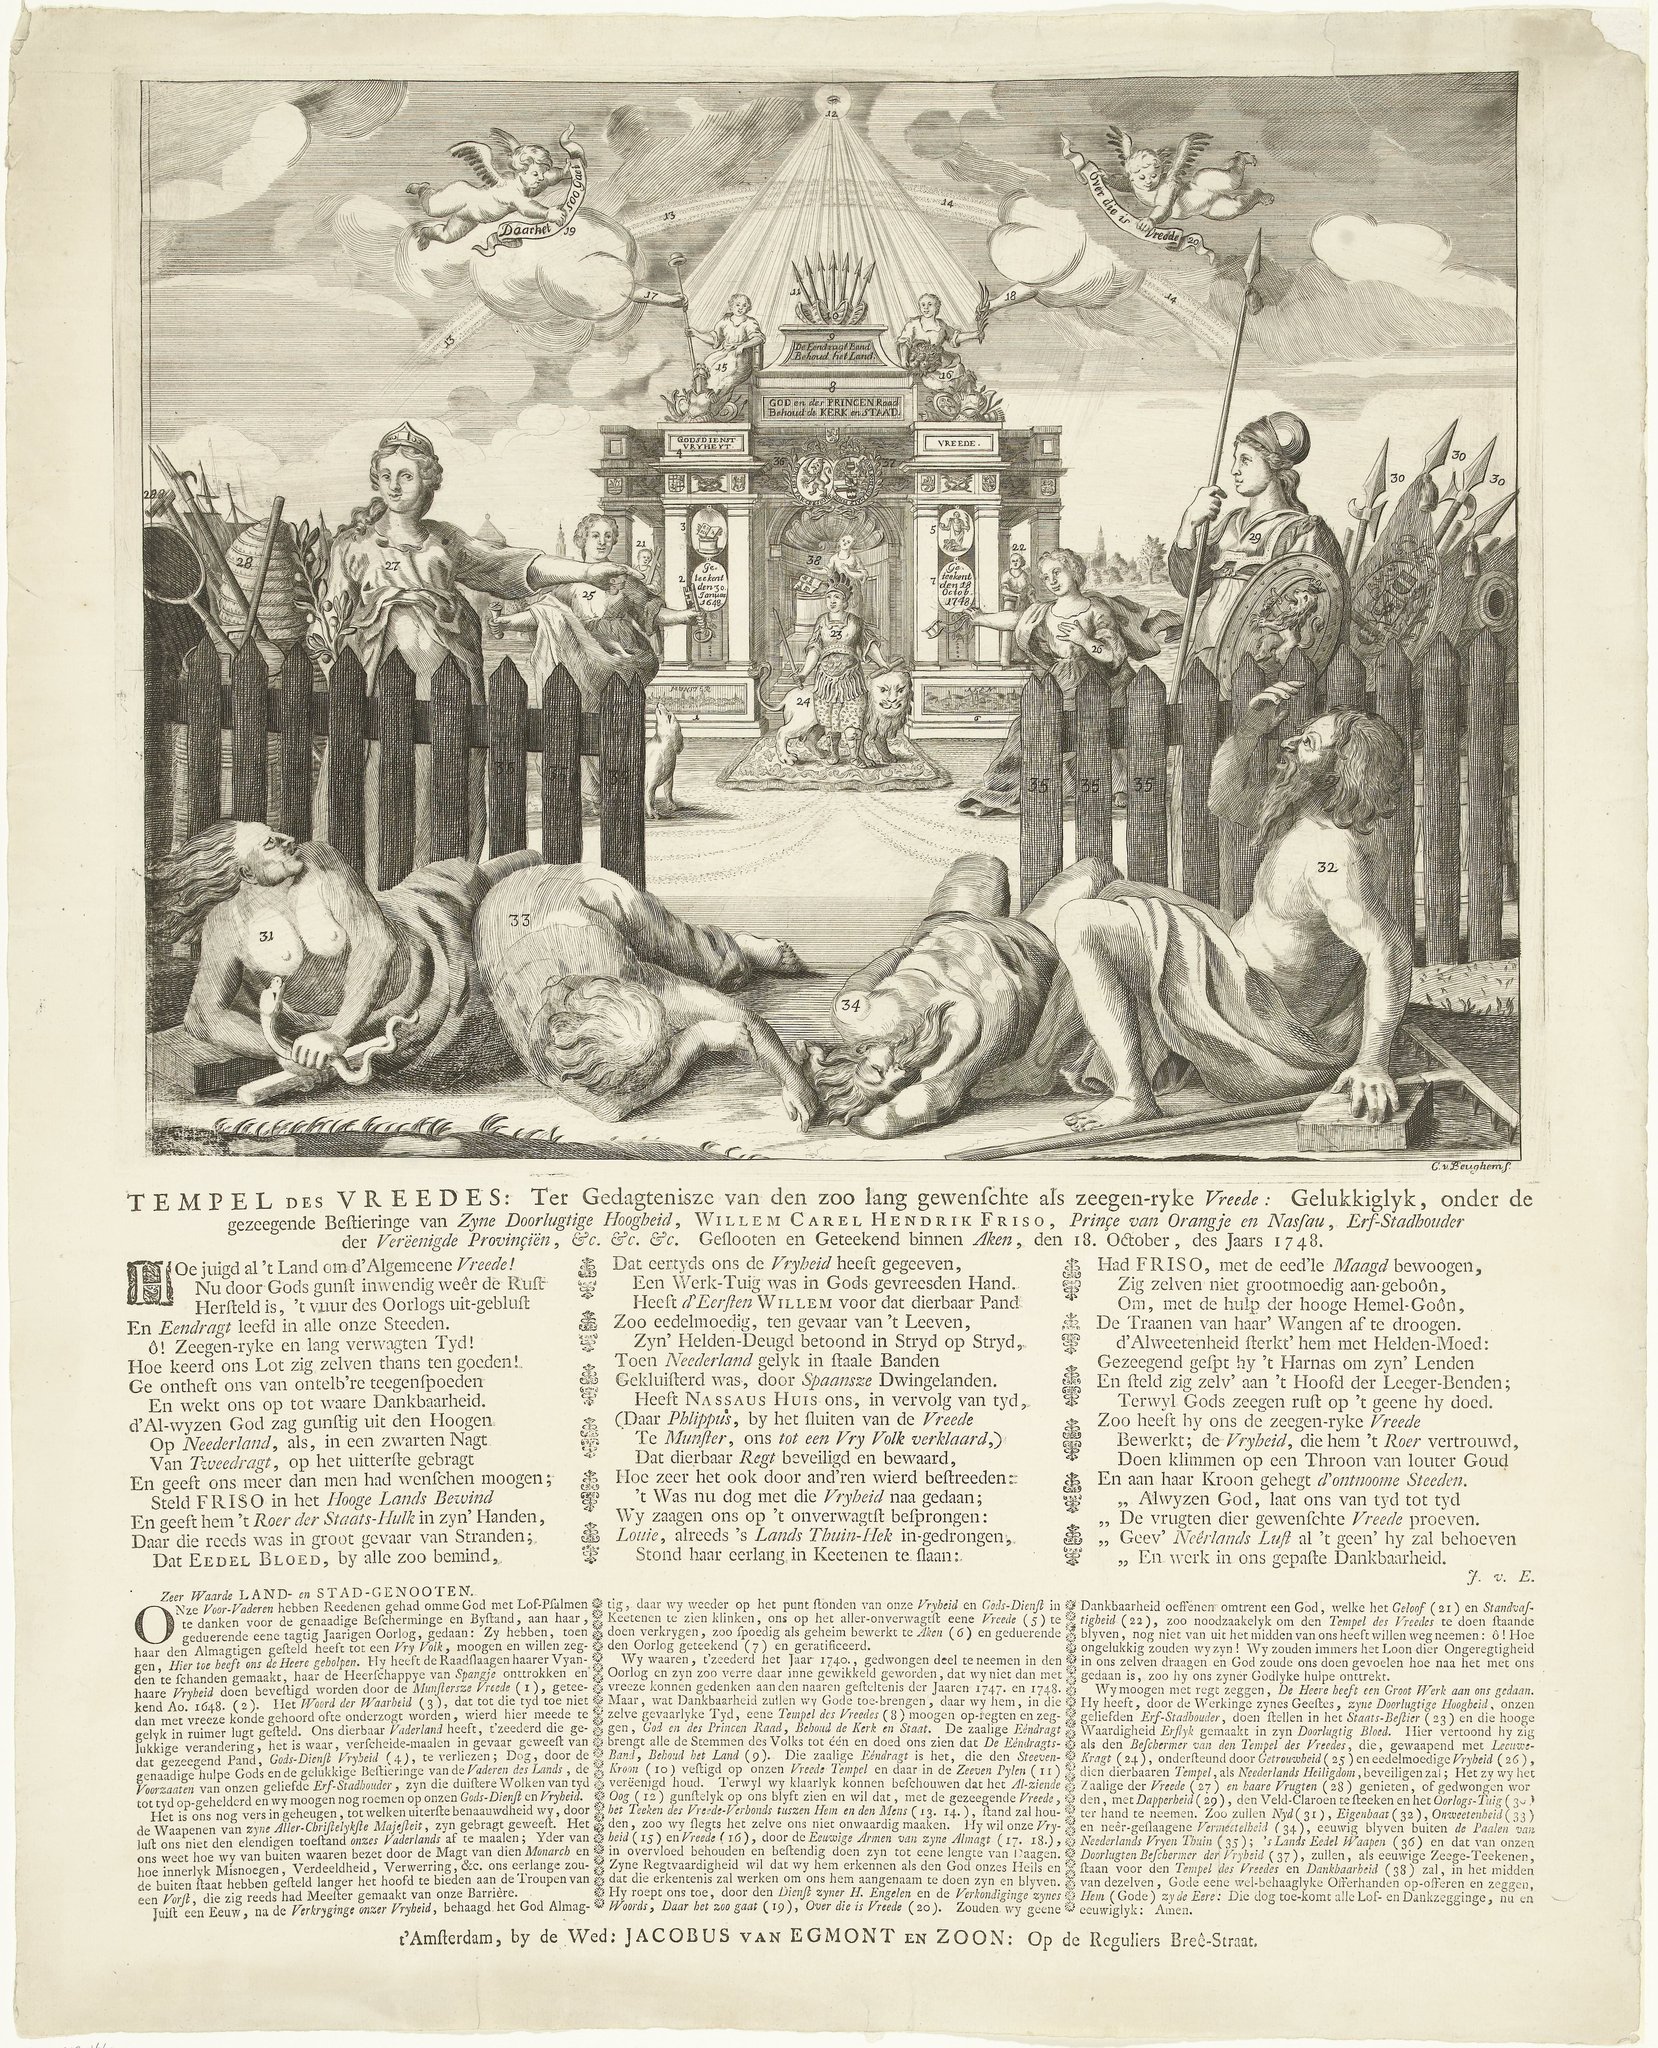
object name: print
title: Allegorie op de vrede van Aken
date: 1749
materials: paper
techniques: engraving, letterpress printing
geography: amsterdam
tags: the hague, willem iv (prins van oranje-nassau)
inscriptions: collector's mark: Lugt 2233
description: Allegorie op de vrede van Aken welke werd gesloten op 18 oktober 1748 met verheerlijking van Willem IV, prins van Oranje-Nassau, die met de Hollandse leeuw voor de vredestempel staat. Onder de prent staat in boekdruk een verklarende tekst met verwijzing naar de nummers op de voorstelling. De tekst spreekt dankbaarheid uit voor het behoud van godsdienst en vrijheid, sinds de Vrede van Munster (1648) verschillende malen in gevaar gebracht maar door de rol van de prins en God behouden voor het vaderland.